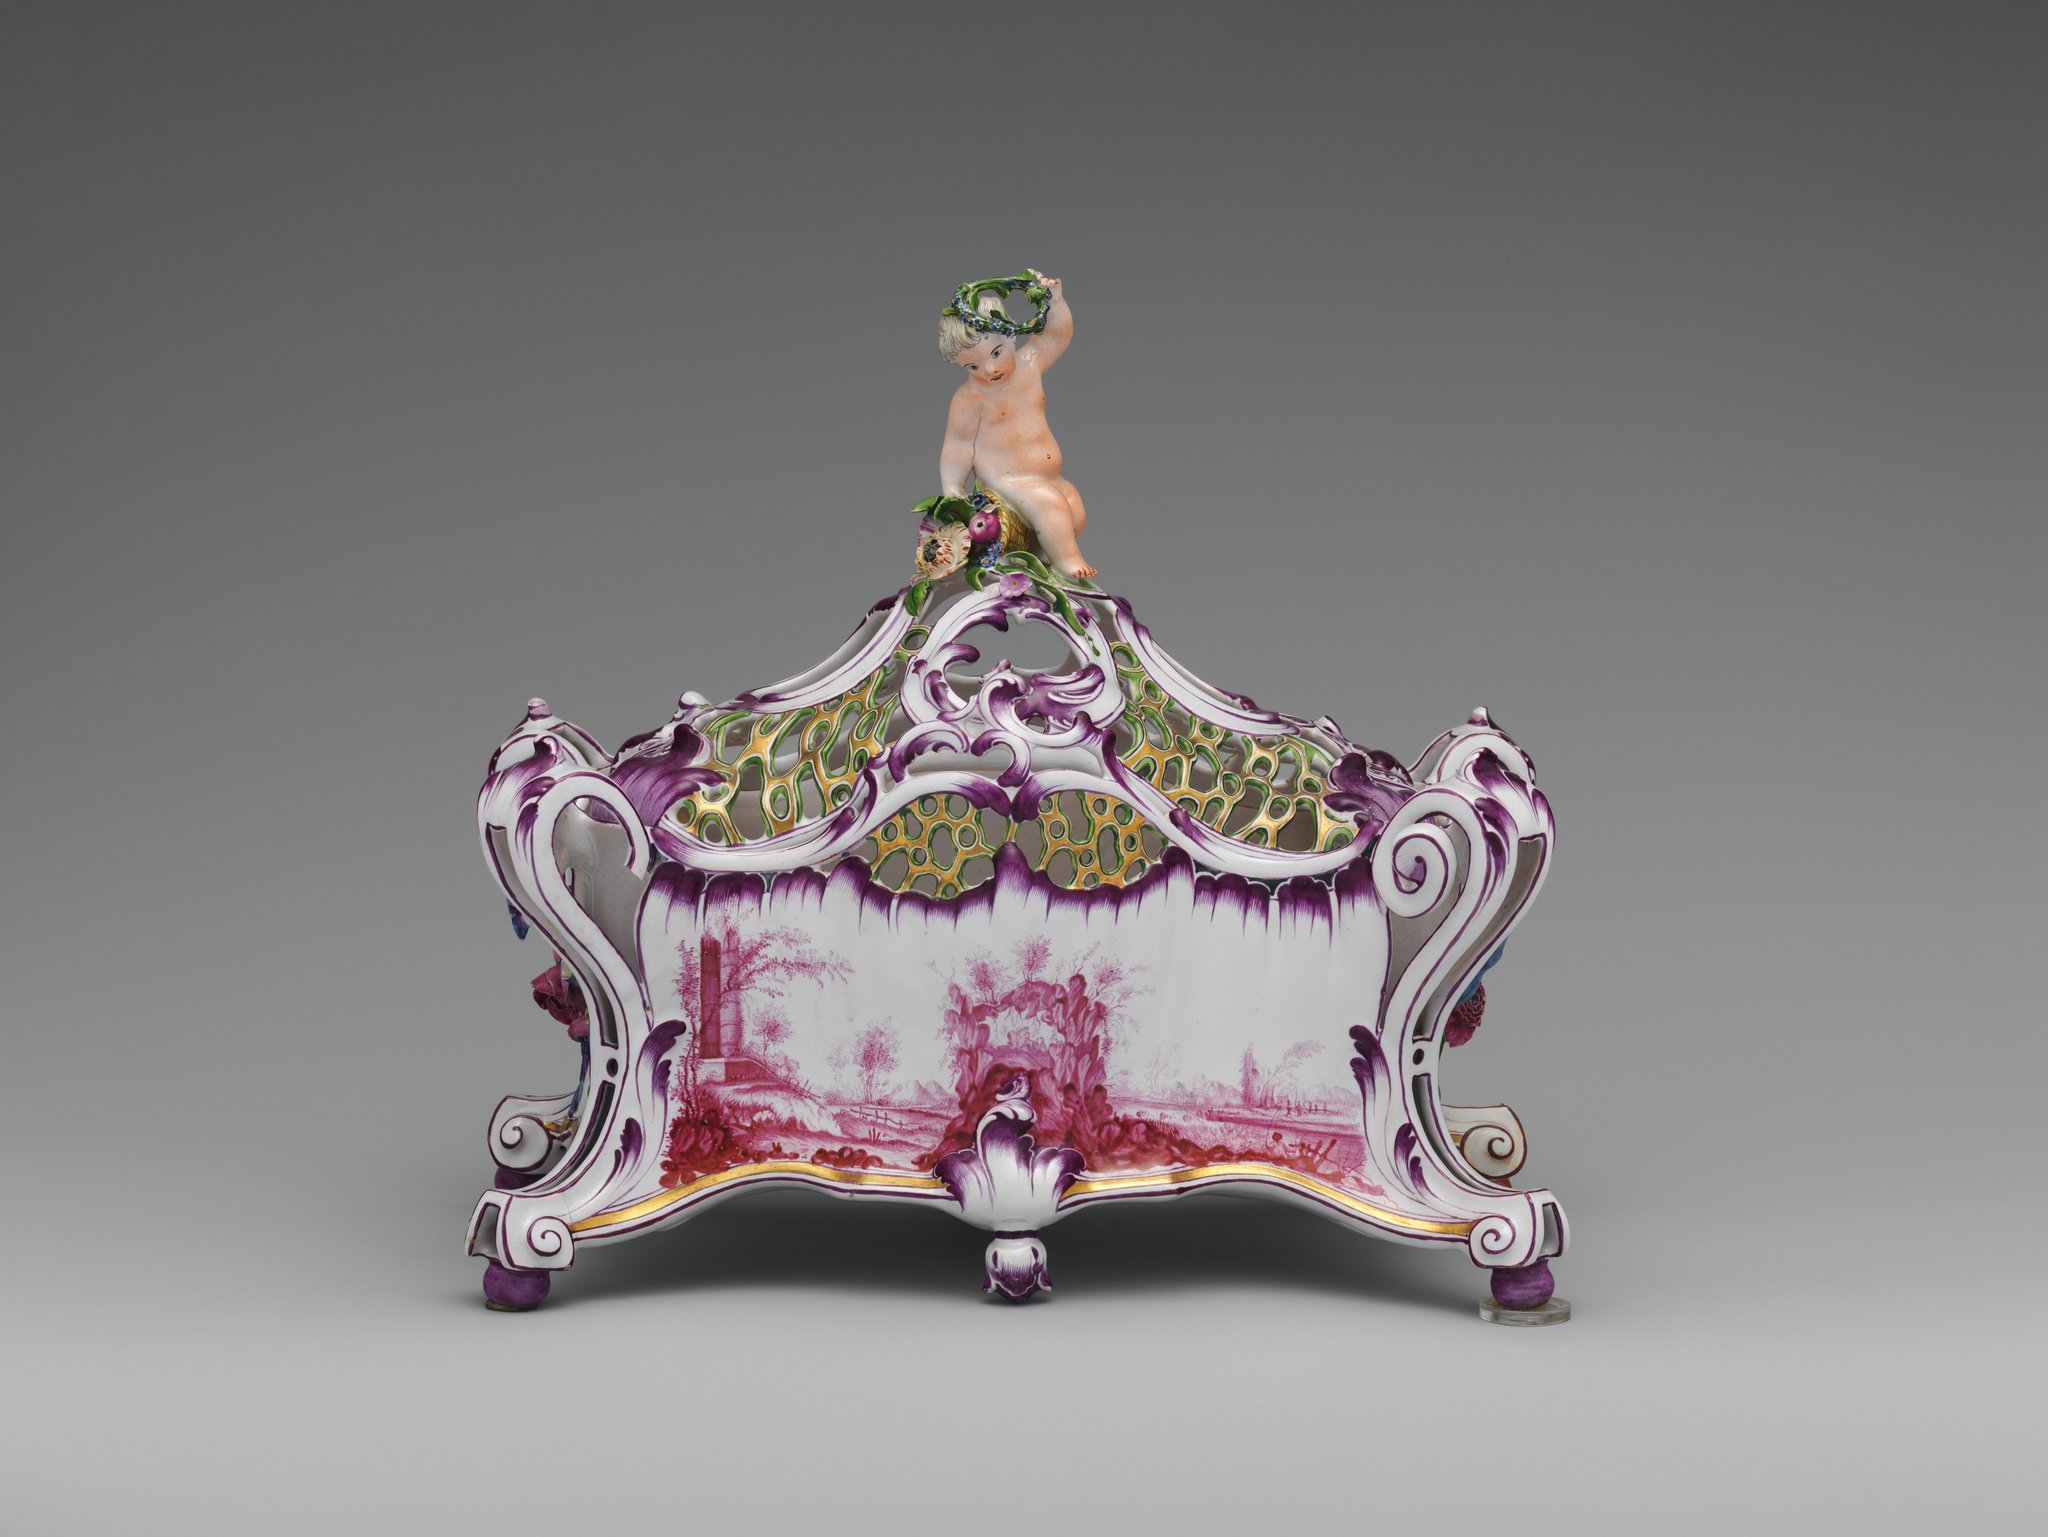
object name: potpourri with cover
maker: niderviller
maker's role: factory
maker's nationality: french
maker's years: 1735-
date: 1760-1765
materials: faience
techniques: glazing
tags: putti